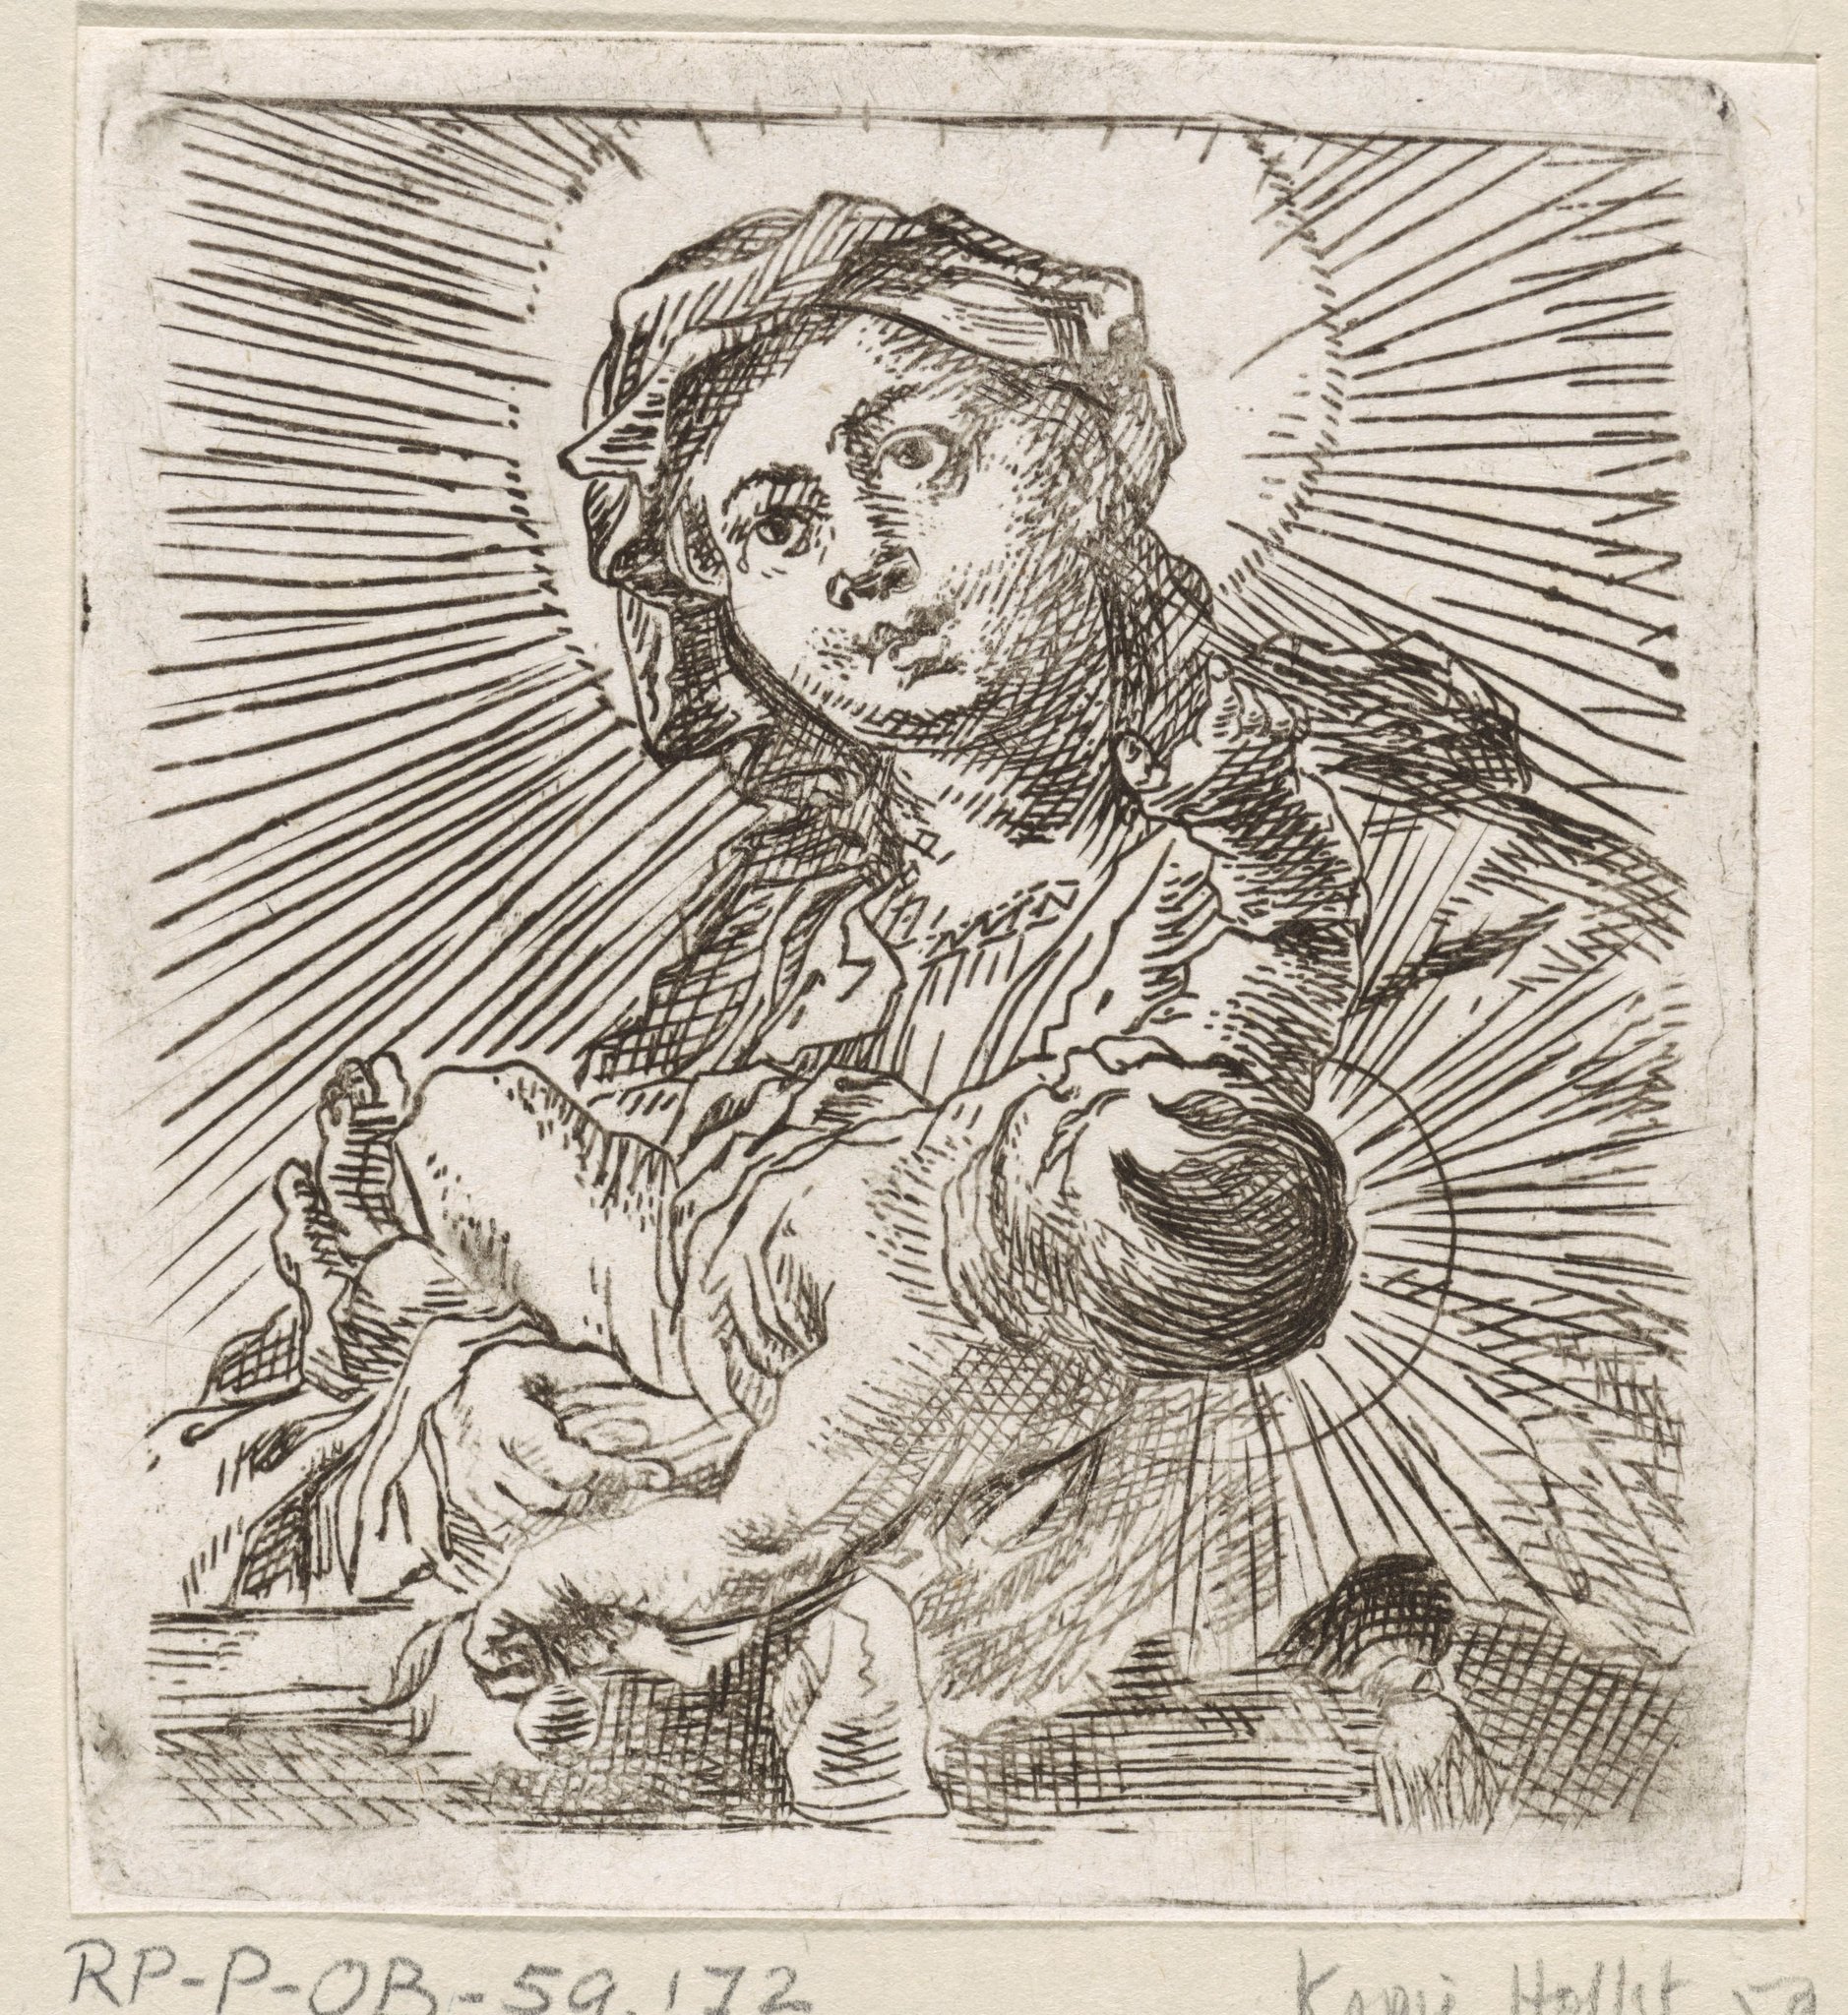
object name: print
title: Madonna met kind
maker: cornelis schut (i)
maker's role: draughtsman, print maker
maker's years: 1597-1655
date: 1618-1655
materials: paper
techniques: etching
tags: madonna: mary sitting or enthroned, the christ-child in her lap (or in front of her bosom) (mary sometimes represented half-length)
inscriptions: collector's mark: Lugt 240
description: Maria draagt het Christuskind in haar armen. Hij wijst omhoog; in zijn andere hand houdt hij een vrucht.